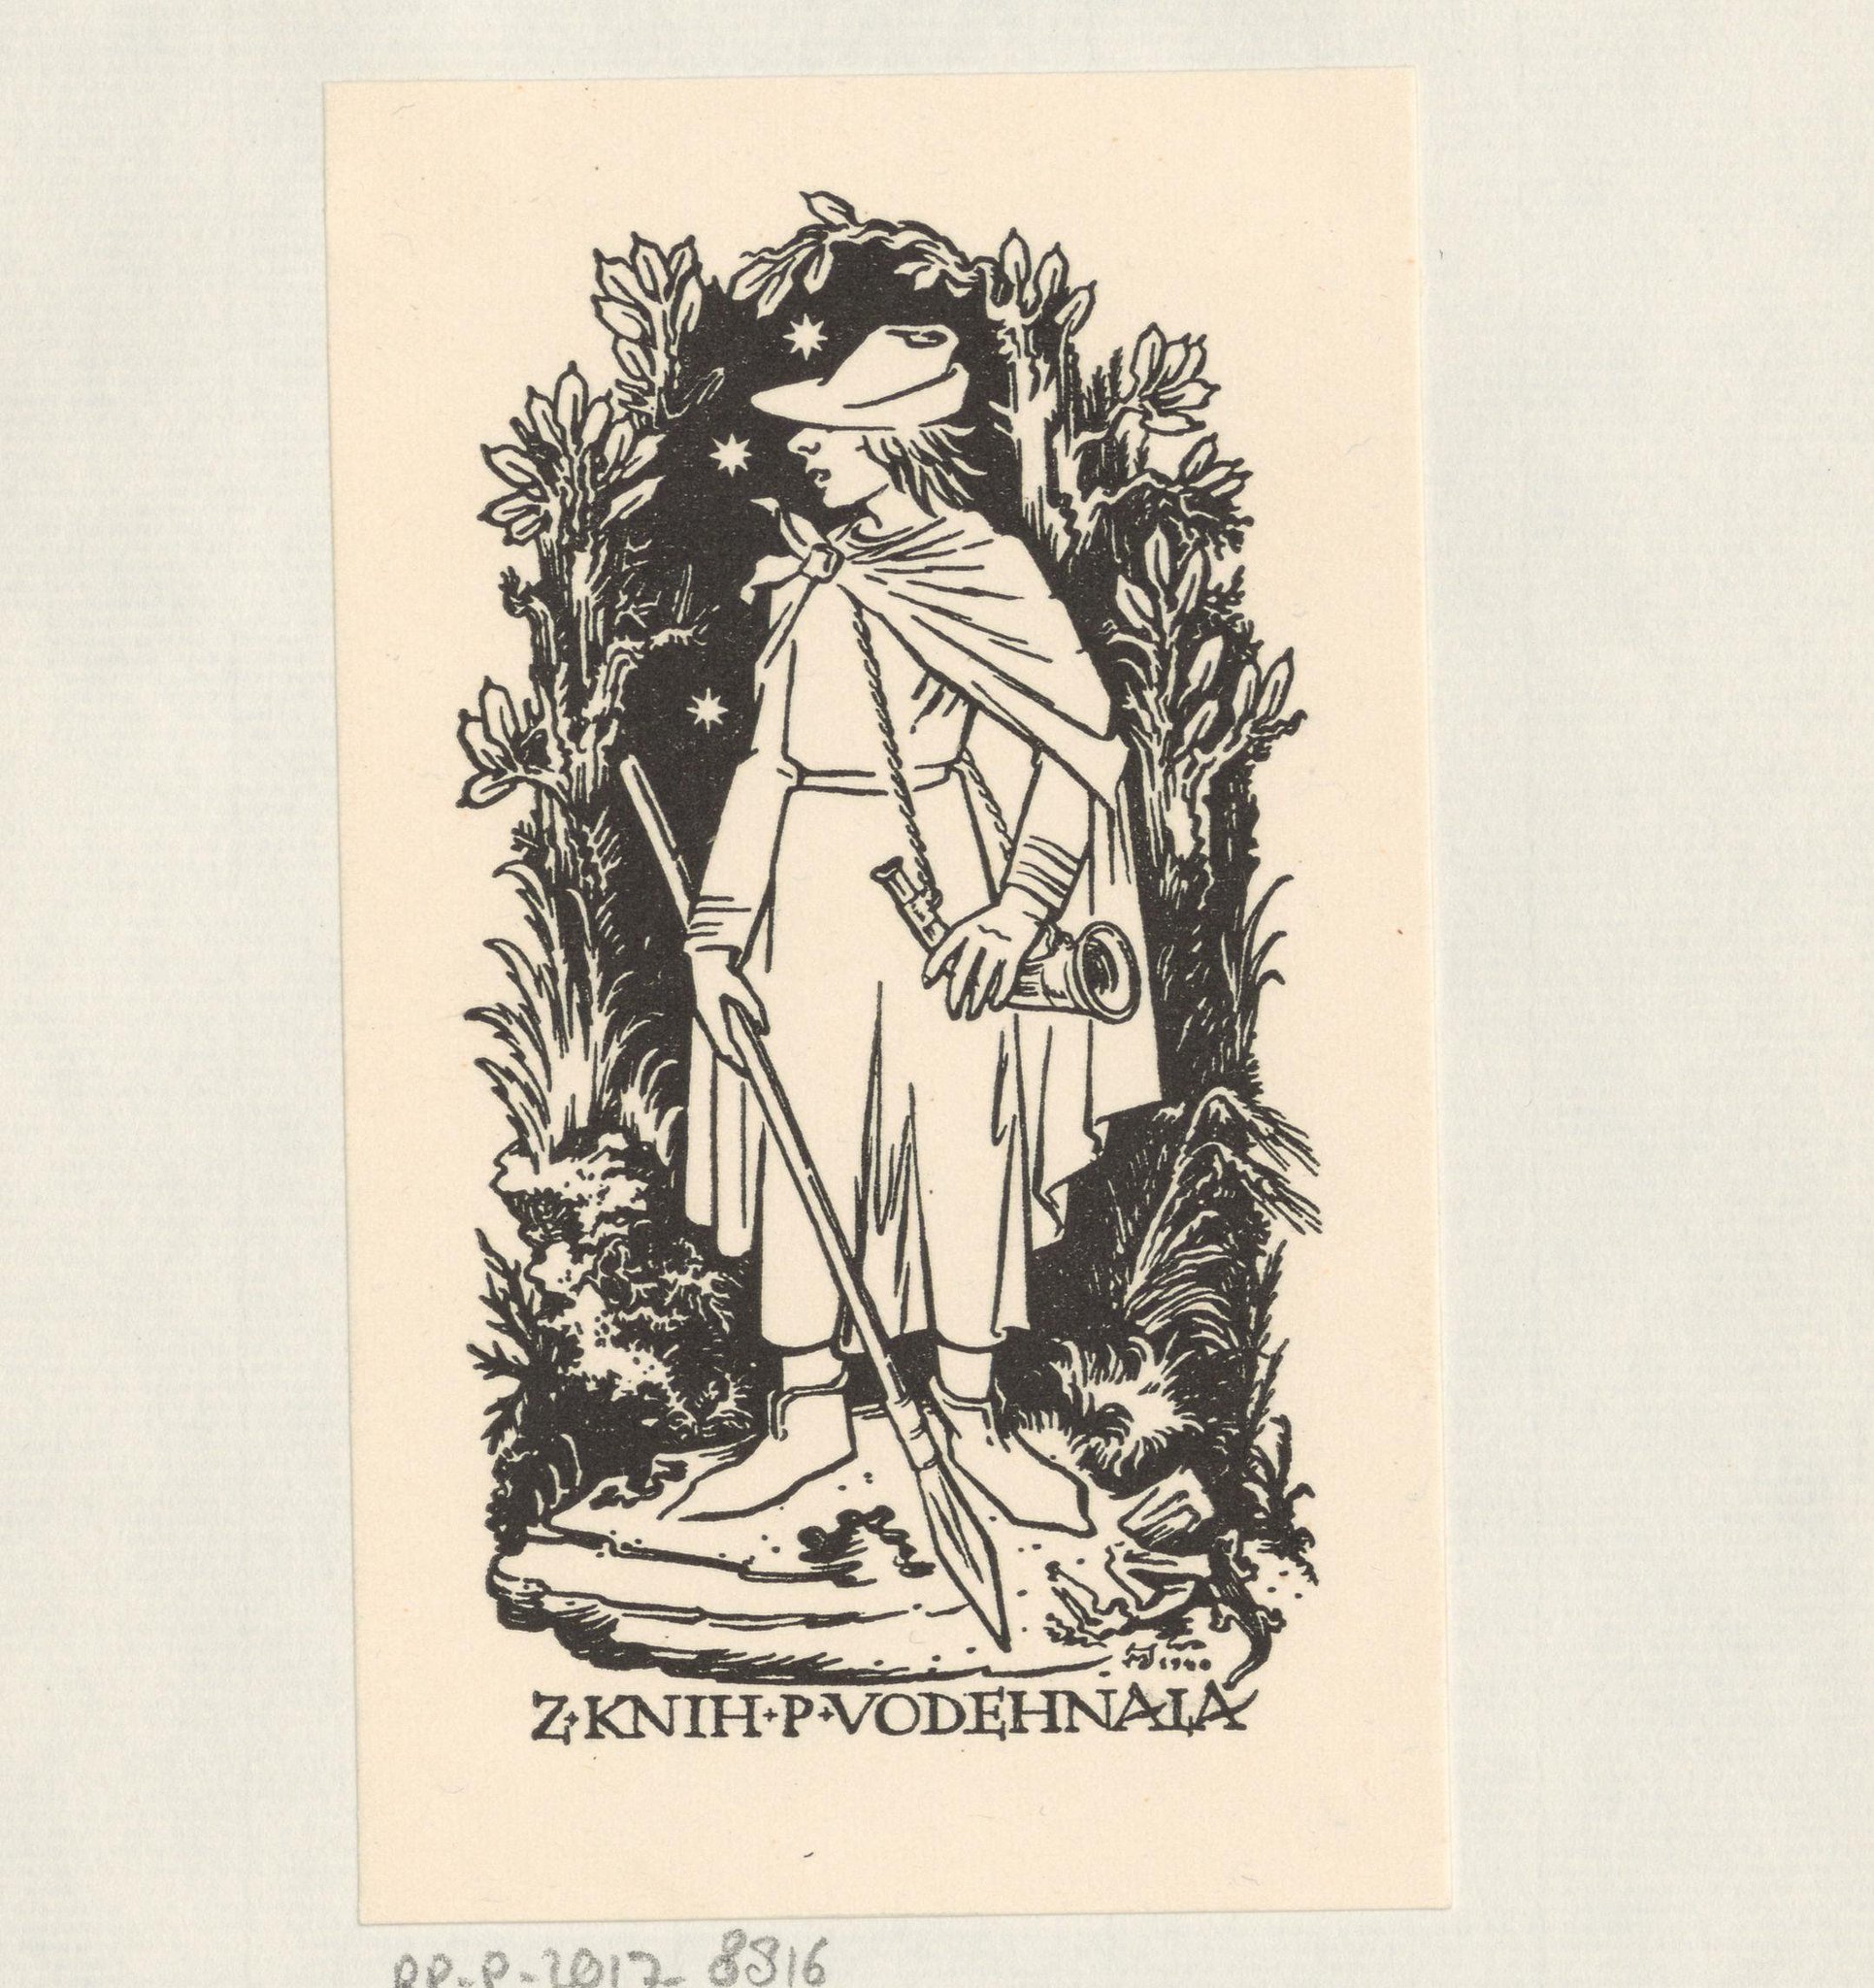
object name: bookplate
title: Z knih P. Vodehnala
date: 1940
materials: paper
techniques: printing block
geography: louny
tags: standing figure, hunter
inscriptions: workshop stamp: ‘Jar. Mařík/ Louny 1940’